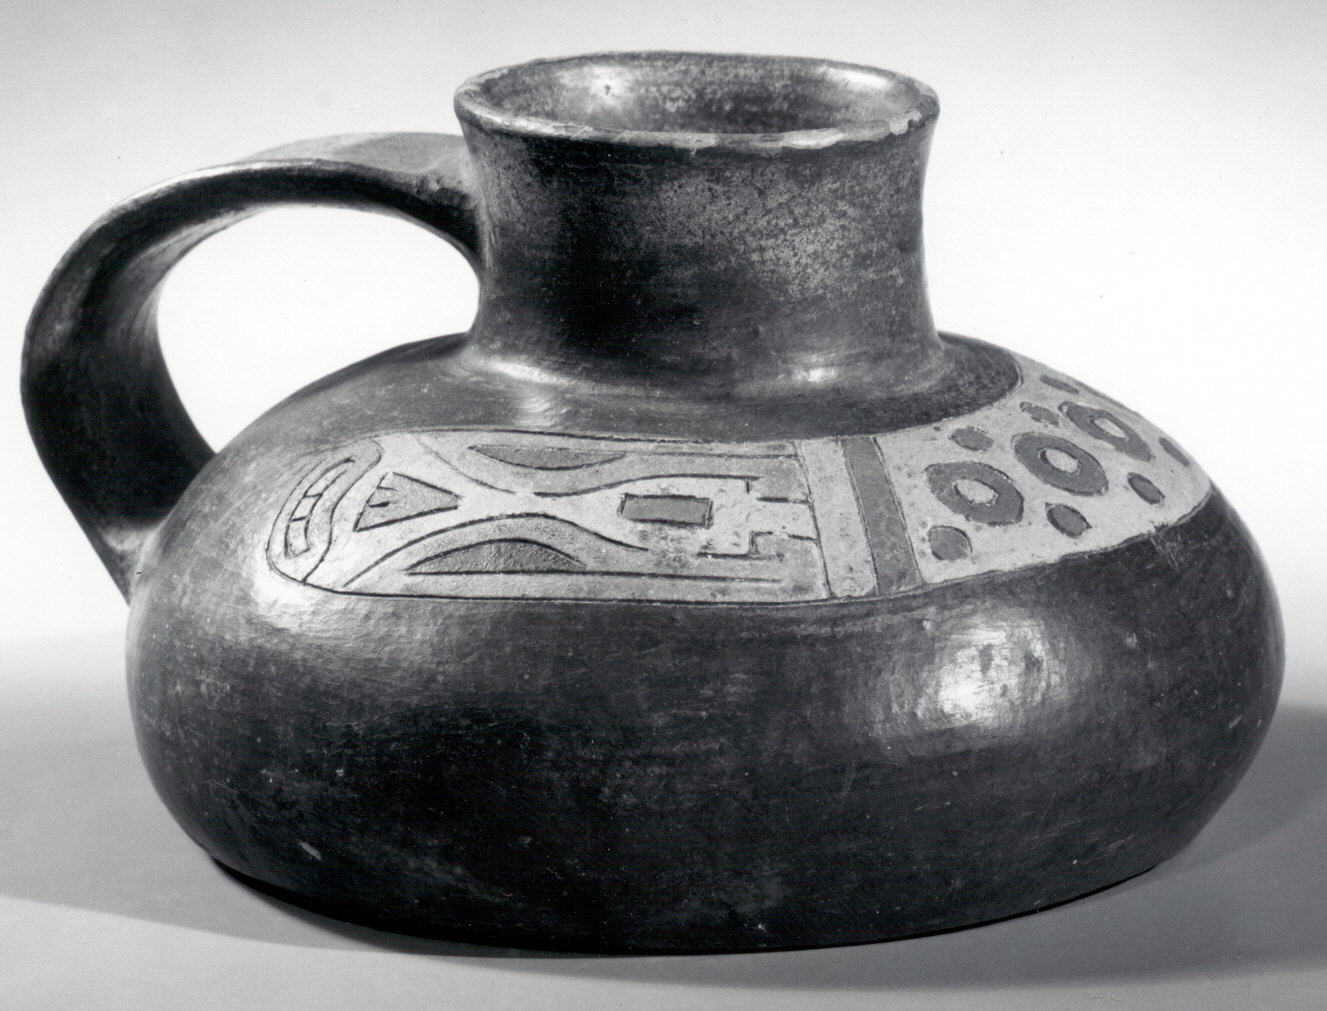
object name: jar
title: Handled Jar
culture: paracas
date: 700-401 BCE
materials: ceramic, paint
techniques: firing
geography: peru